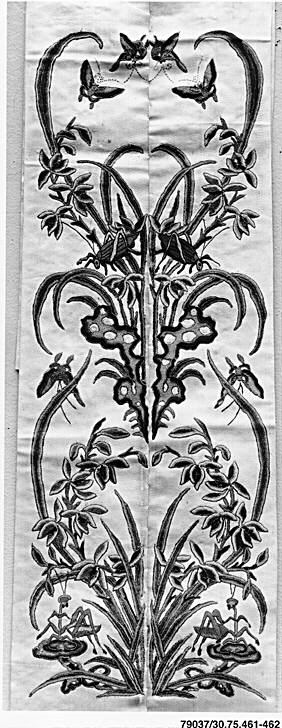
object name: sleeve band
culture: chinese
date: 1801-1900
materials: metal thread, silk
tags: insects,butterflies,plants